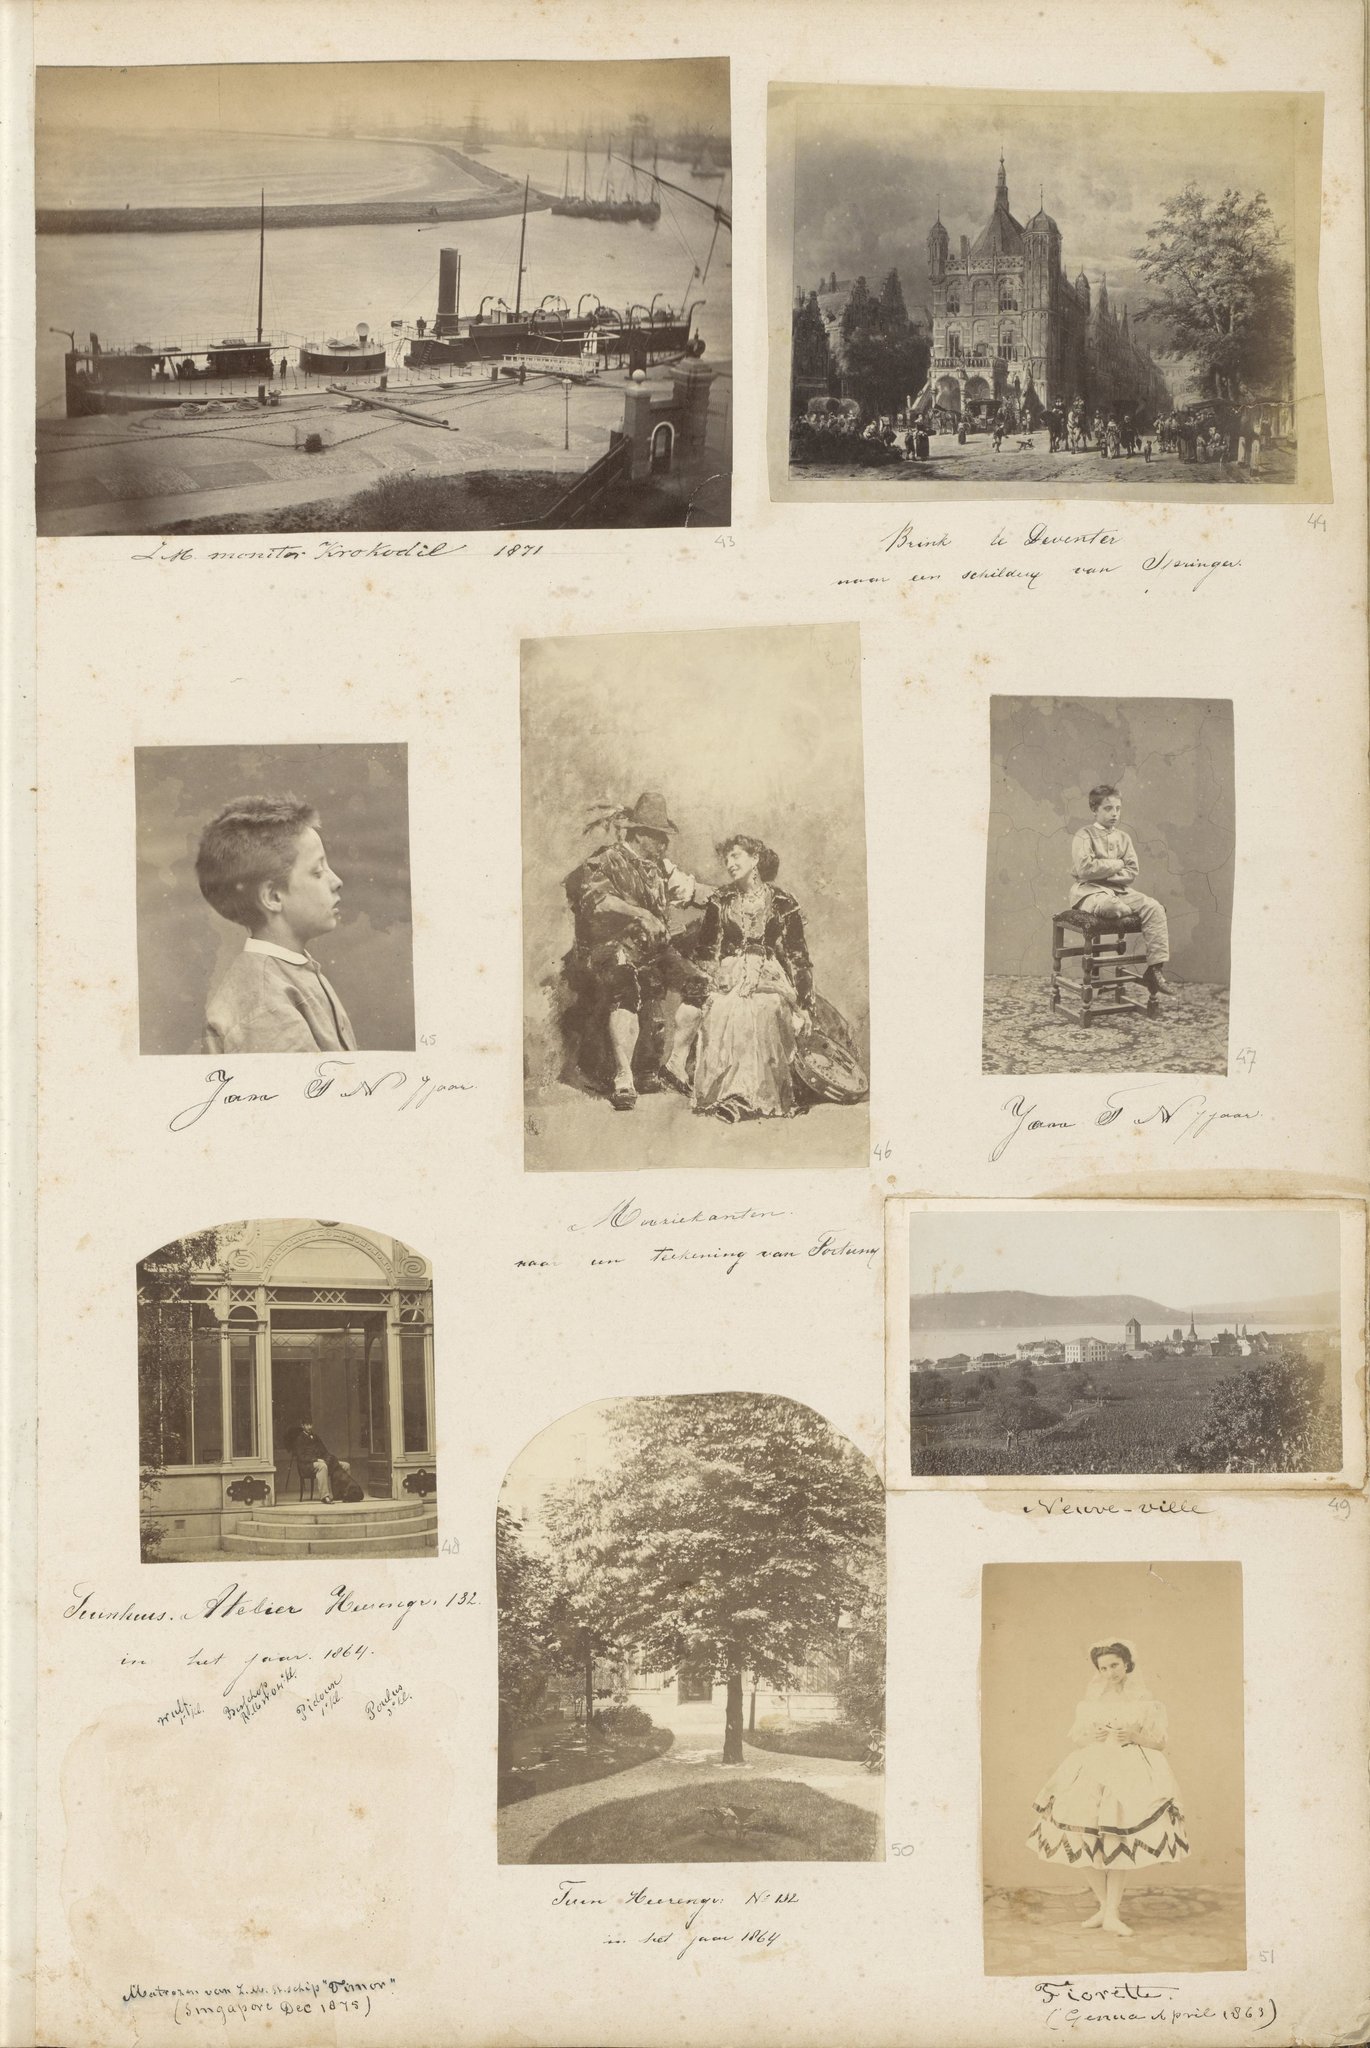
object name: album leaf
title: Gezicht op de tuin achter Herengracht 132 te Amsterdam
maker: Anonymous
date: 1864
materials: paper, photographic support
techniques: albumen print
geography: amsterdam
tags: garden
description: Onderdeel van Fotoalbum van Robert Daniel Crommelin (1841-1907).